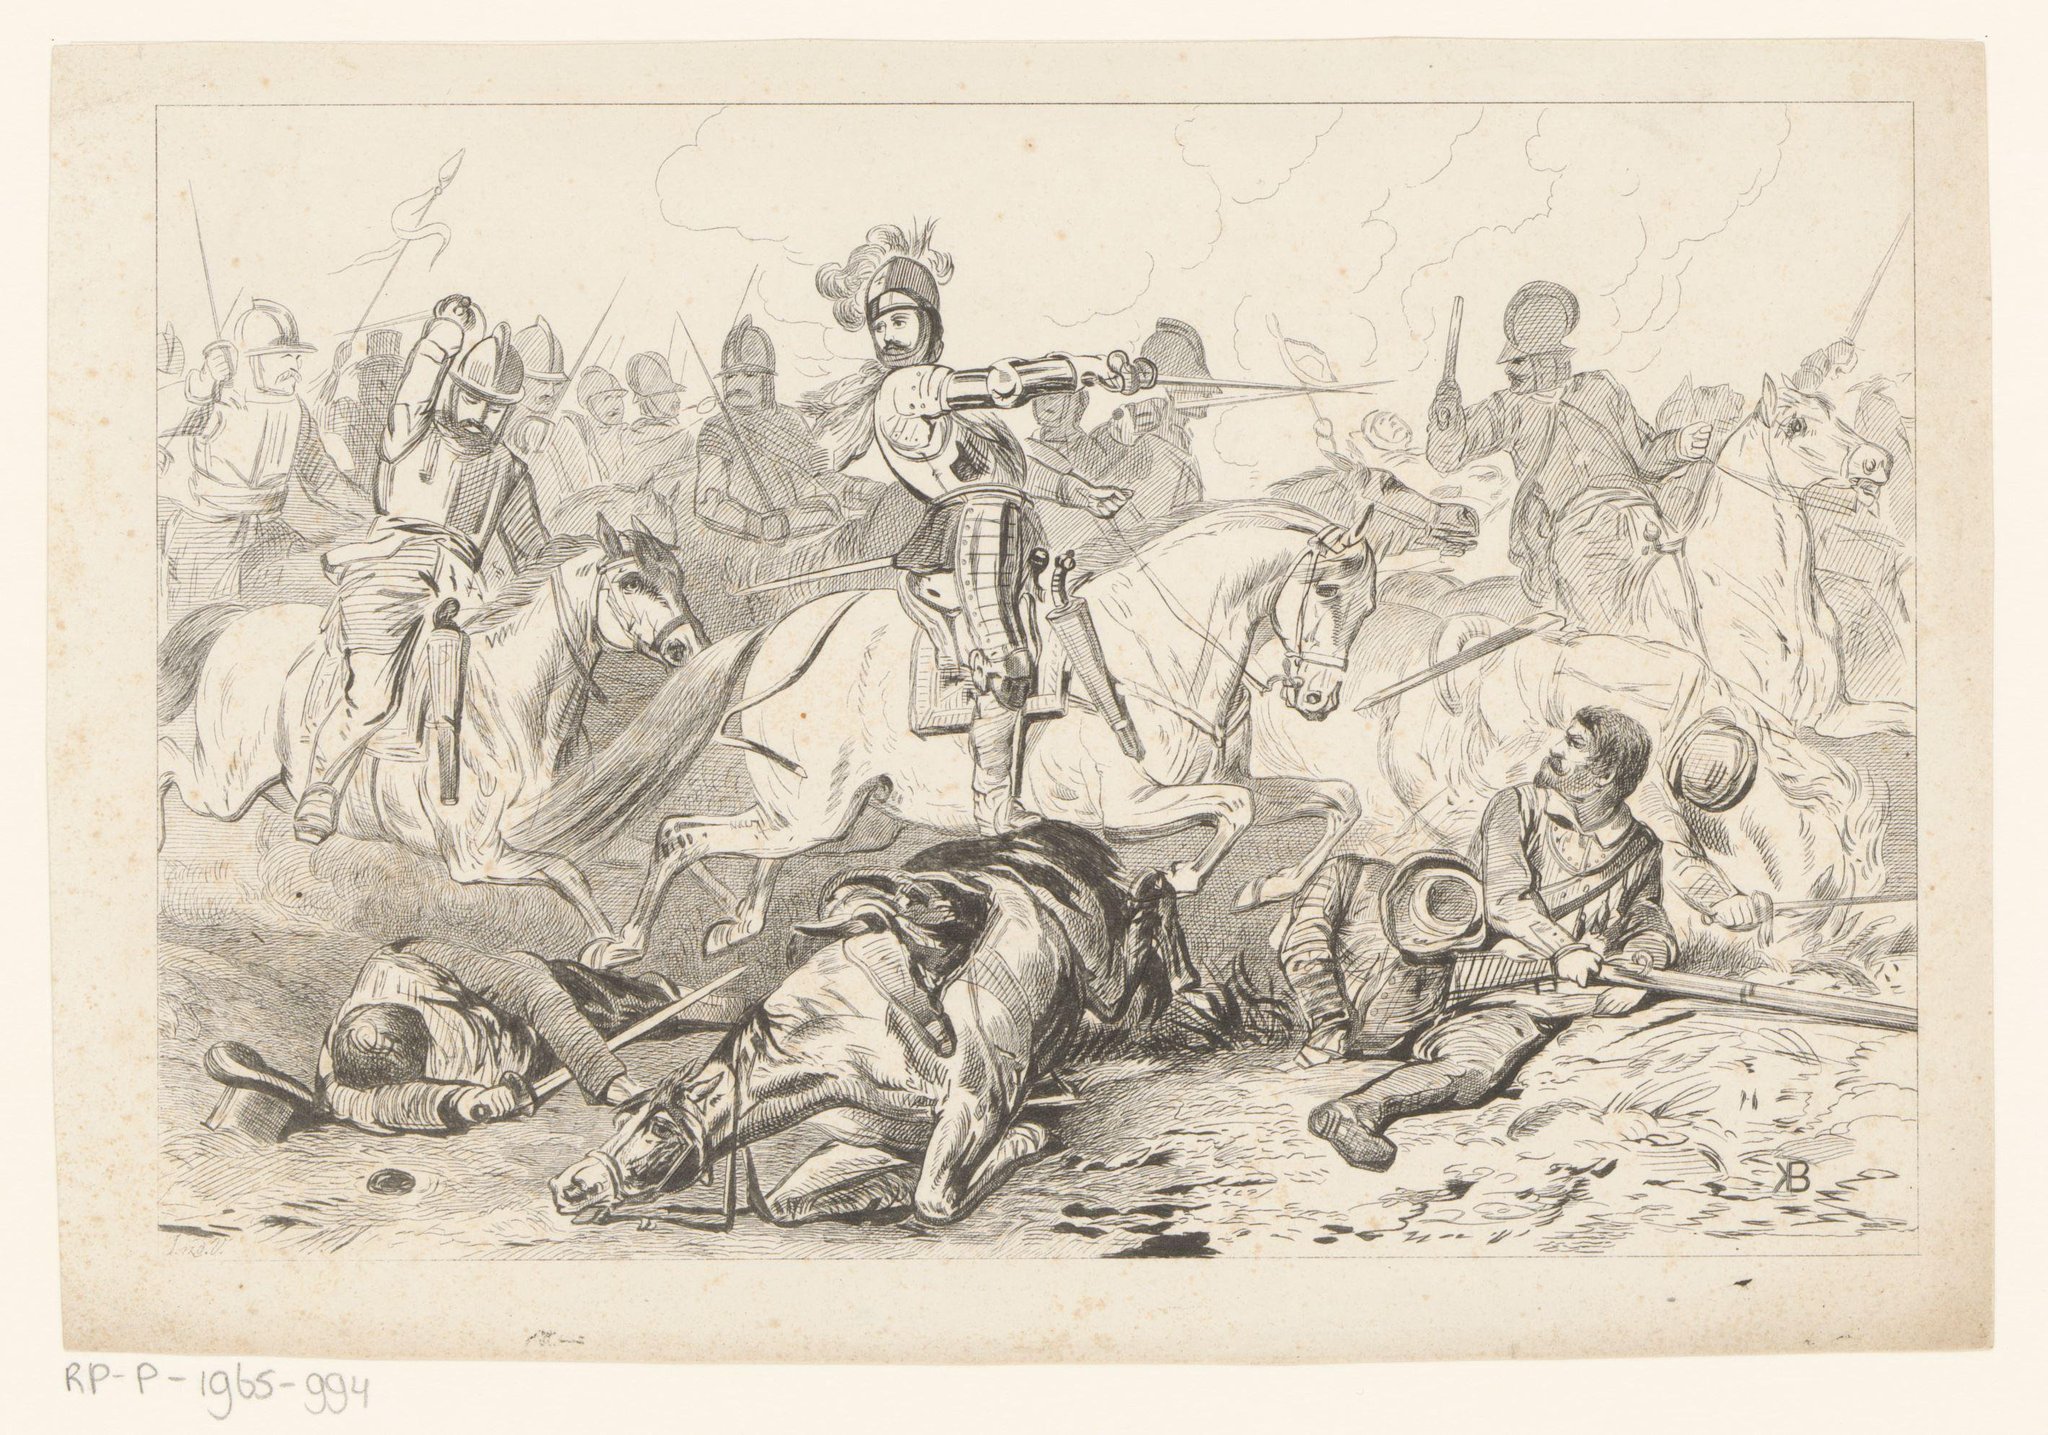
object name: print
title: Slag bij Nieuwpoort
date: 1855-1861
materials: paper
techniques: lithograph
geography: amsterdam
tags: maurice (prince of orange), battle (+ land forces), battle of nieuwpoort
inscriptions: collector's mark: Lugt 2228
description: Strijdtafereel tijdens de slag bij Nieuwpoort, 2 juli 1600. In het midden van het strijdgewoel prins Maurits te paard, wijst met zijn zwaard naar rechts.